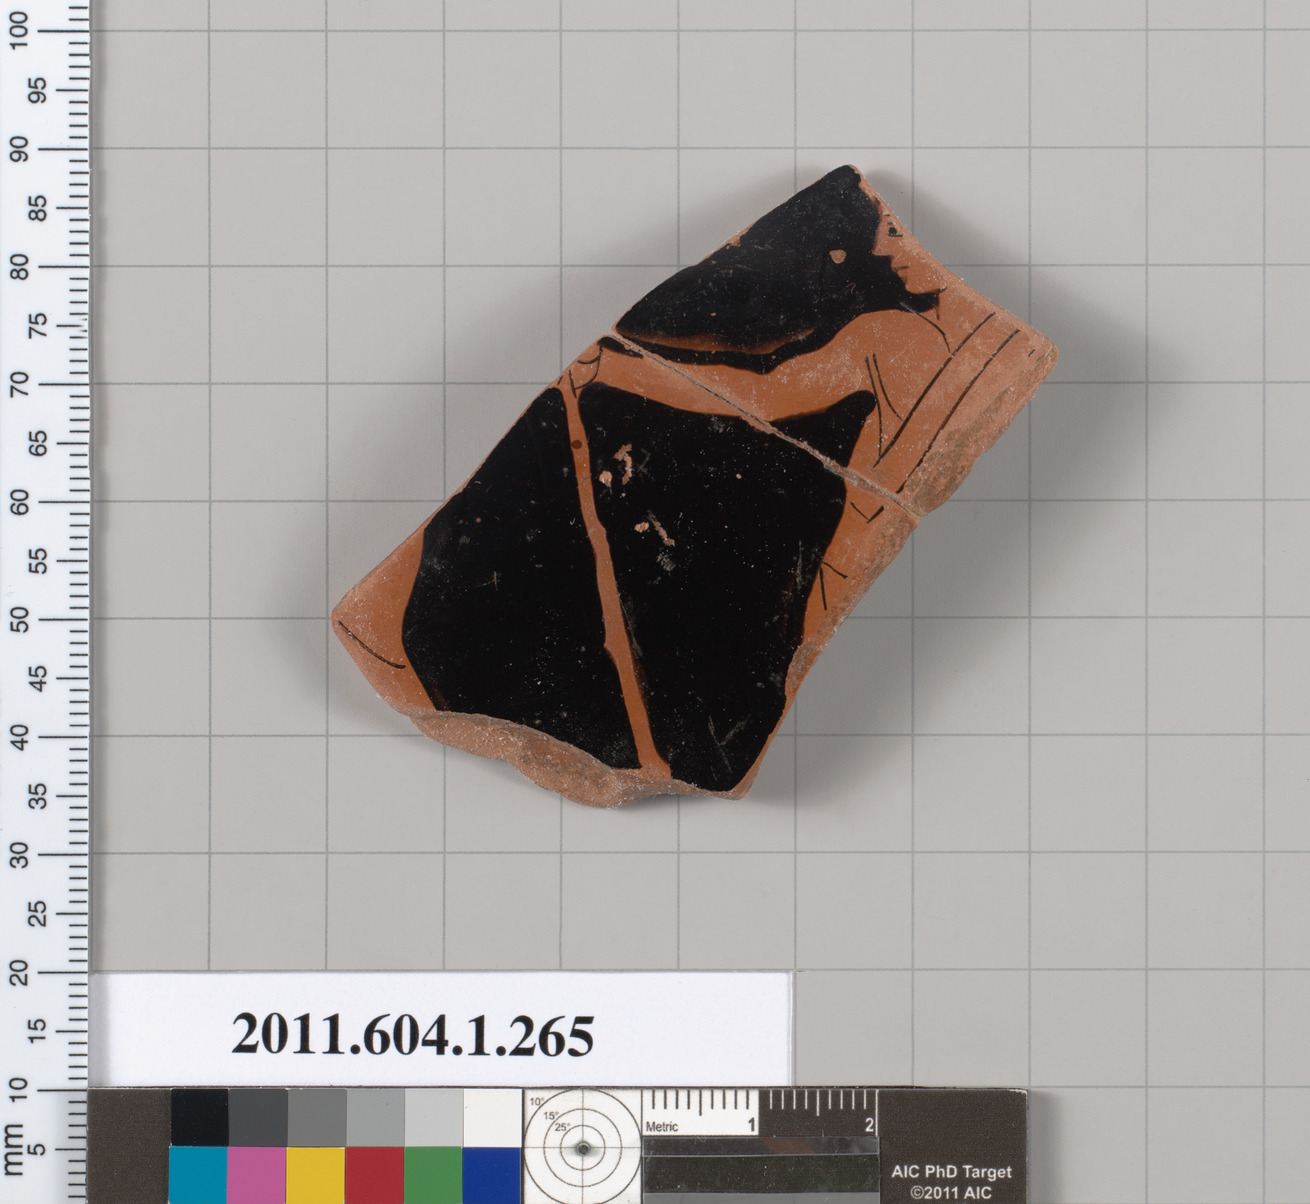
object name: kylix fragment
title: Terracotta fragment of a kylix (drinking cup)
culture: greek, attic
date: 475-451 BCE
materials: terracotta